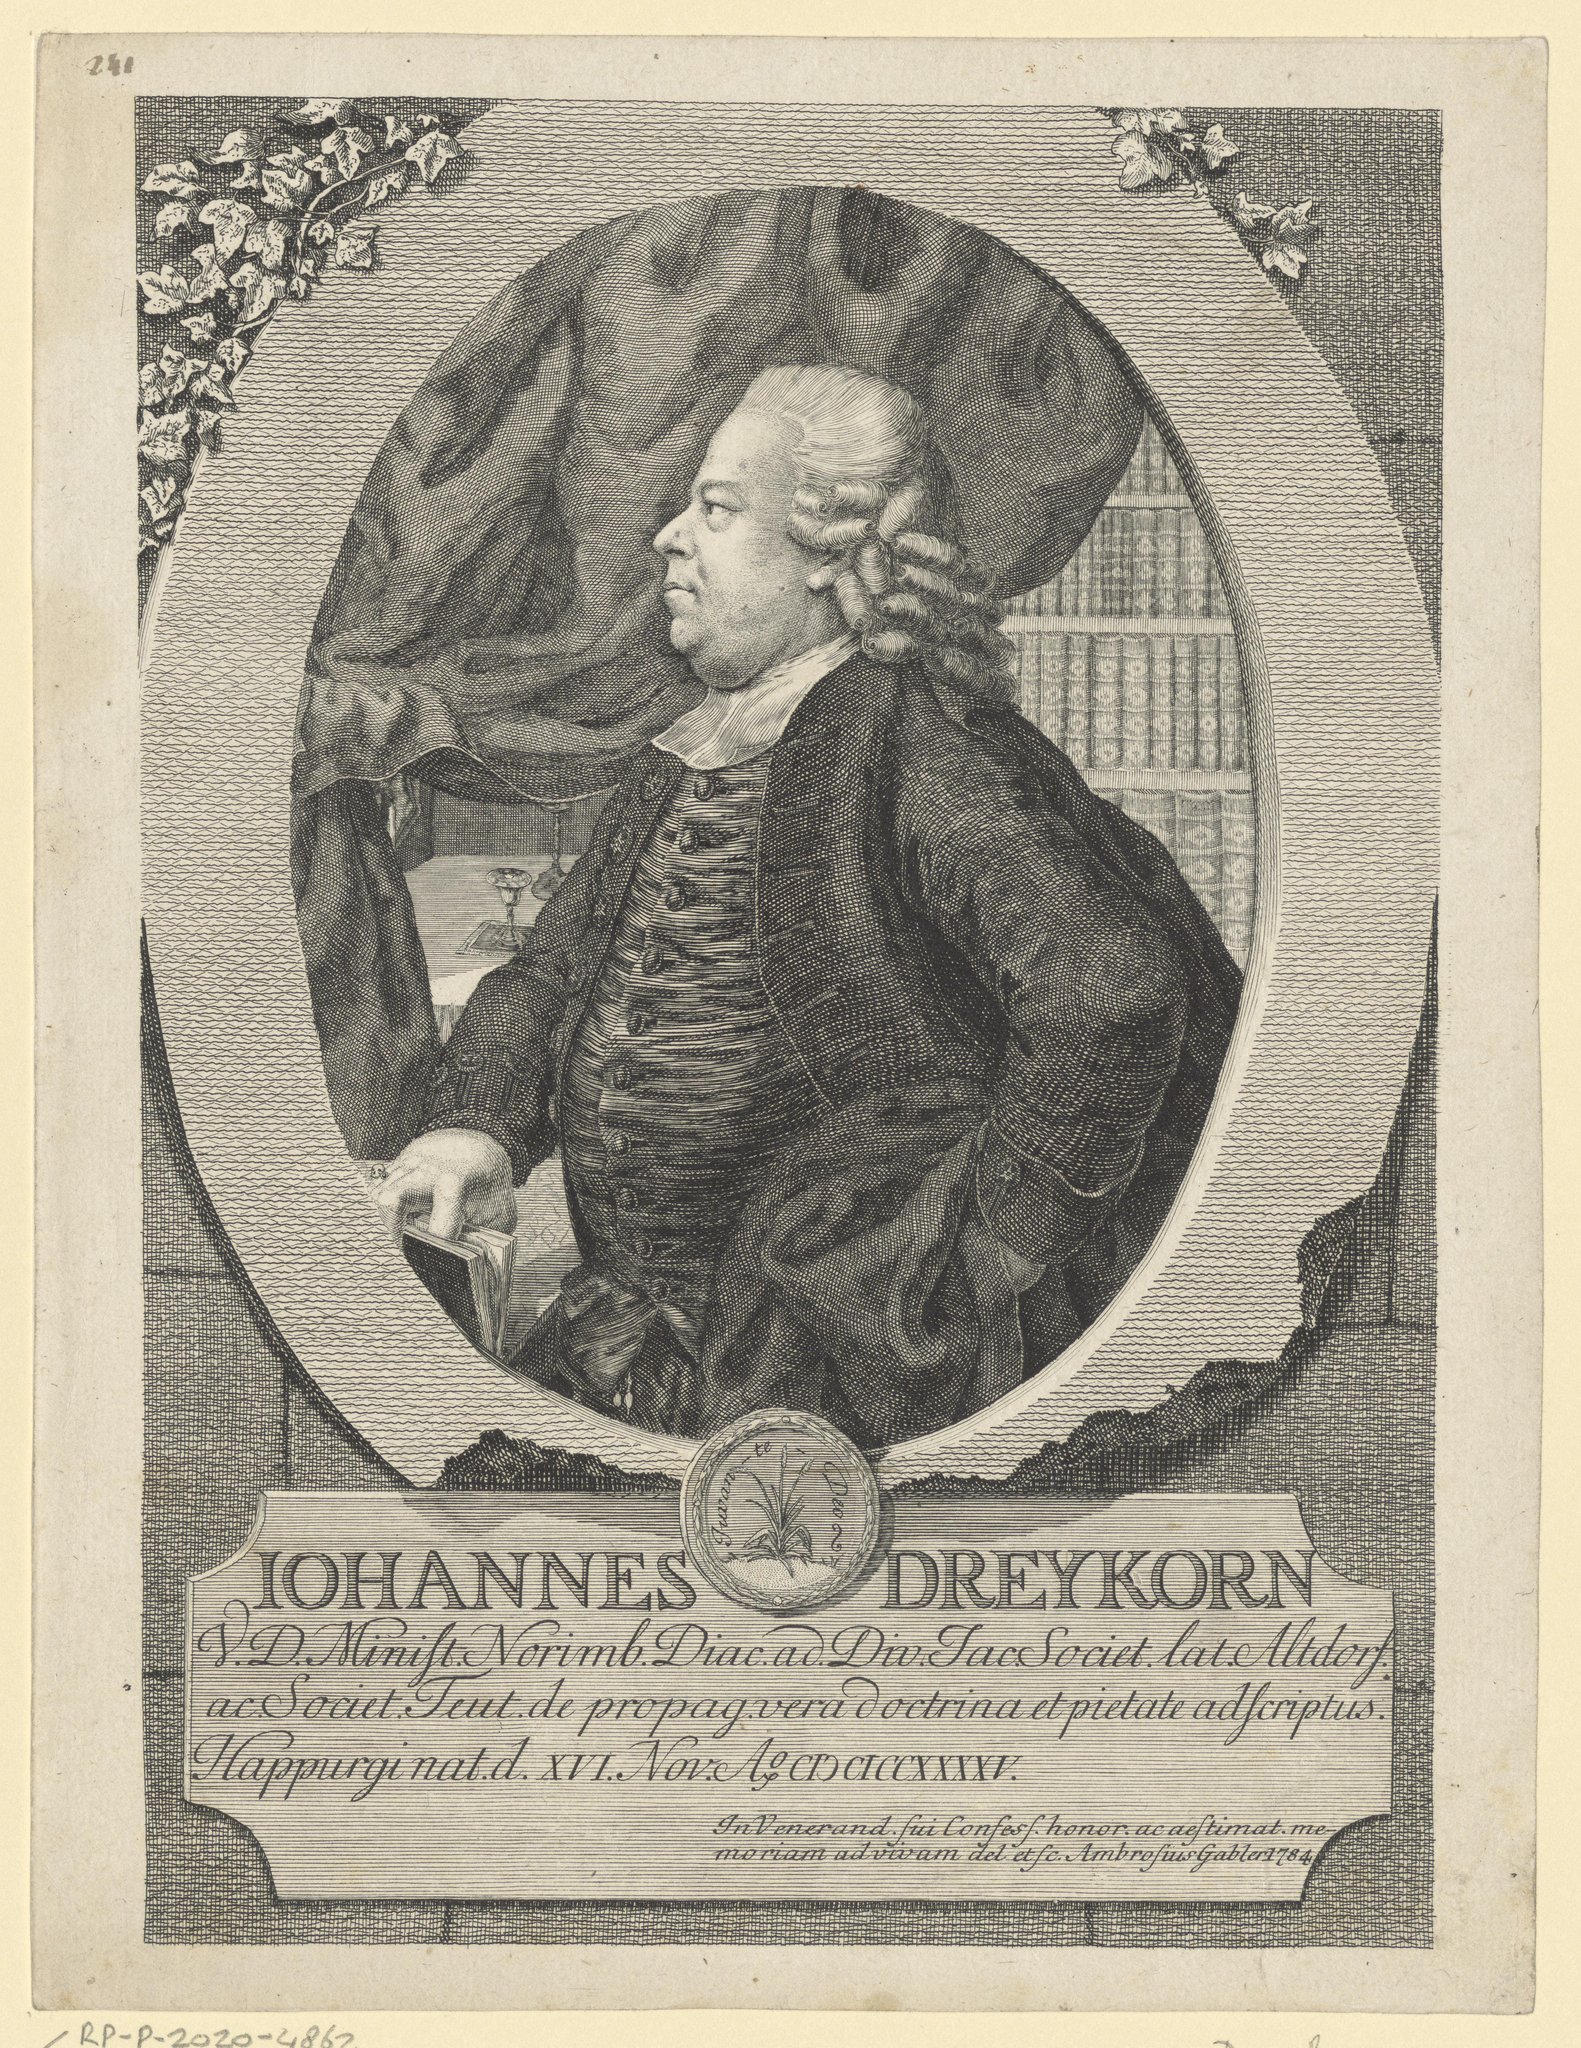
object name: print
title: Portret van Johann Dreykorn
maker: ambrosius gabler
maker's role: print maker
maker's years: 1762-1834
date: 1784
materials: paper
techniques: engraving, etching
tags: historical persons, deacon (roman catholic)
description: In profiel naar links met een boek in zijn linkerhand. Achter hem staan een boekenkast en een tafel.